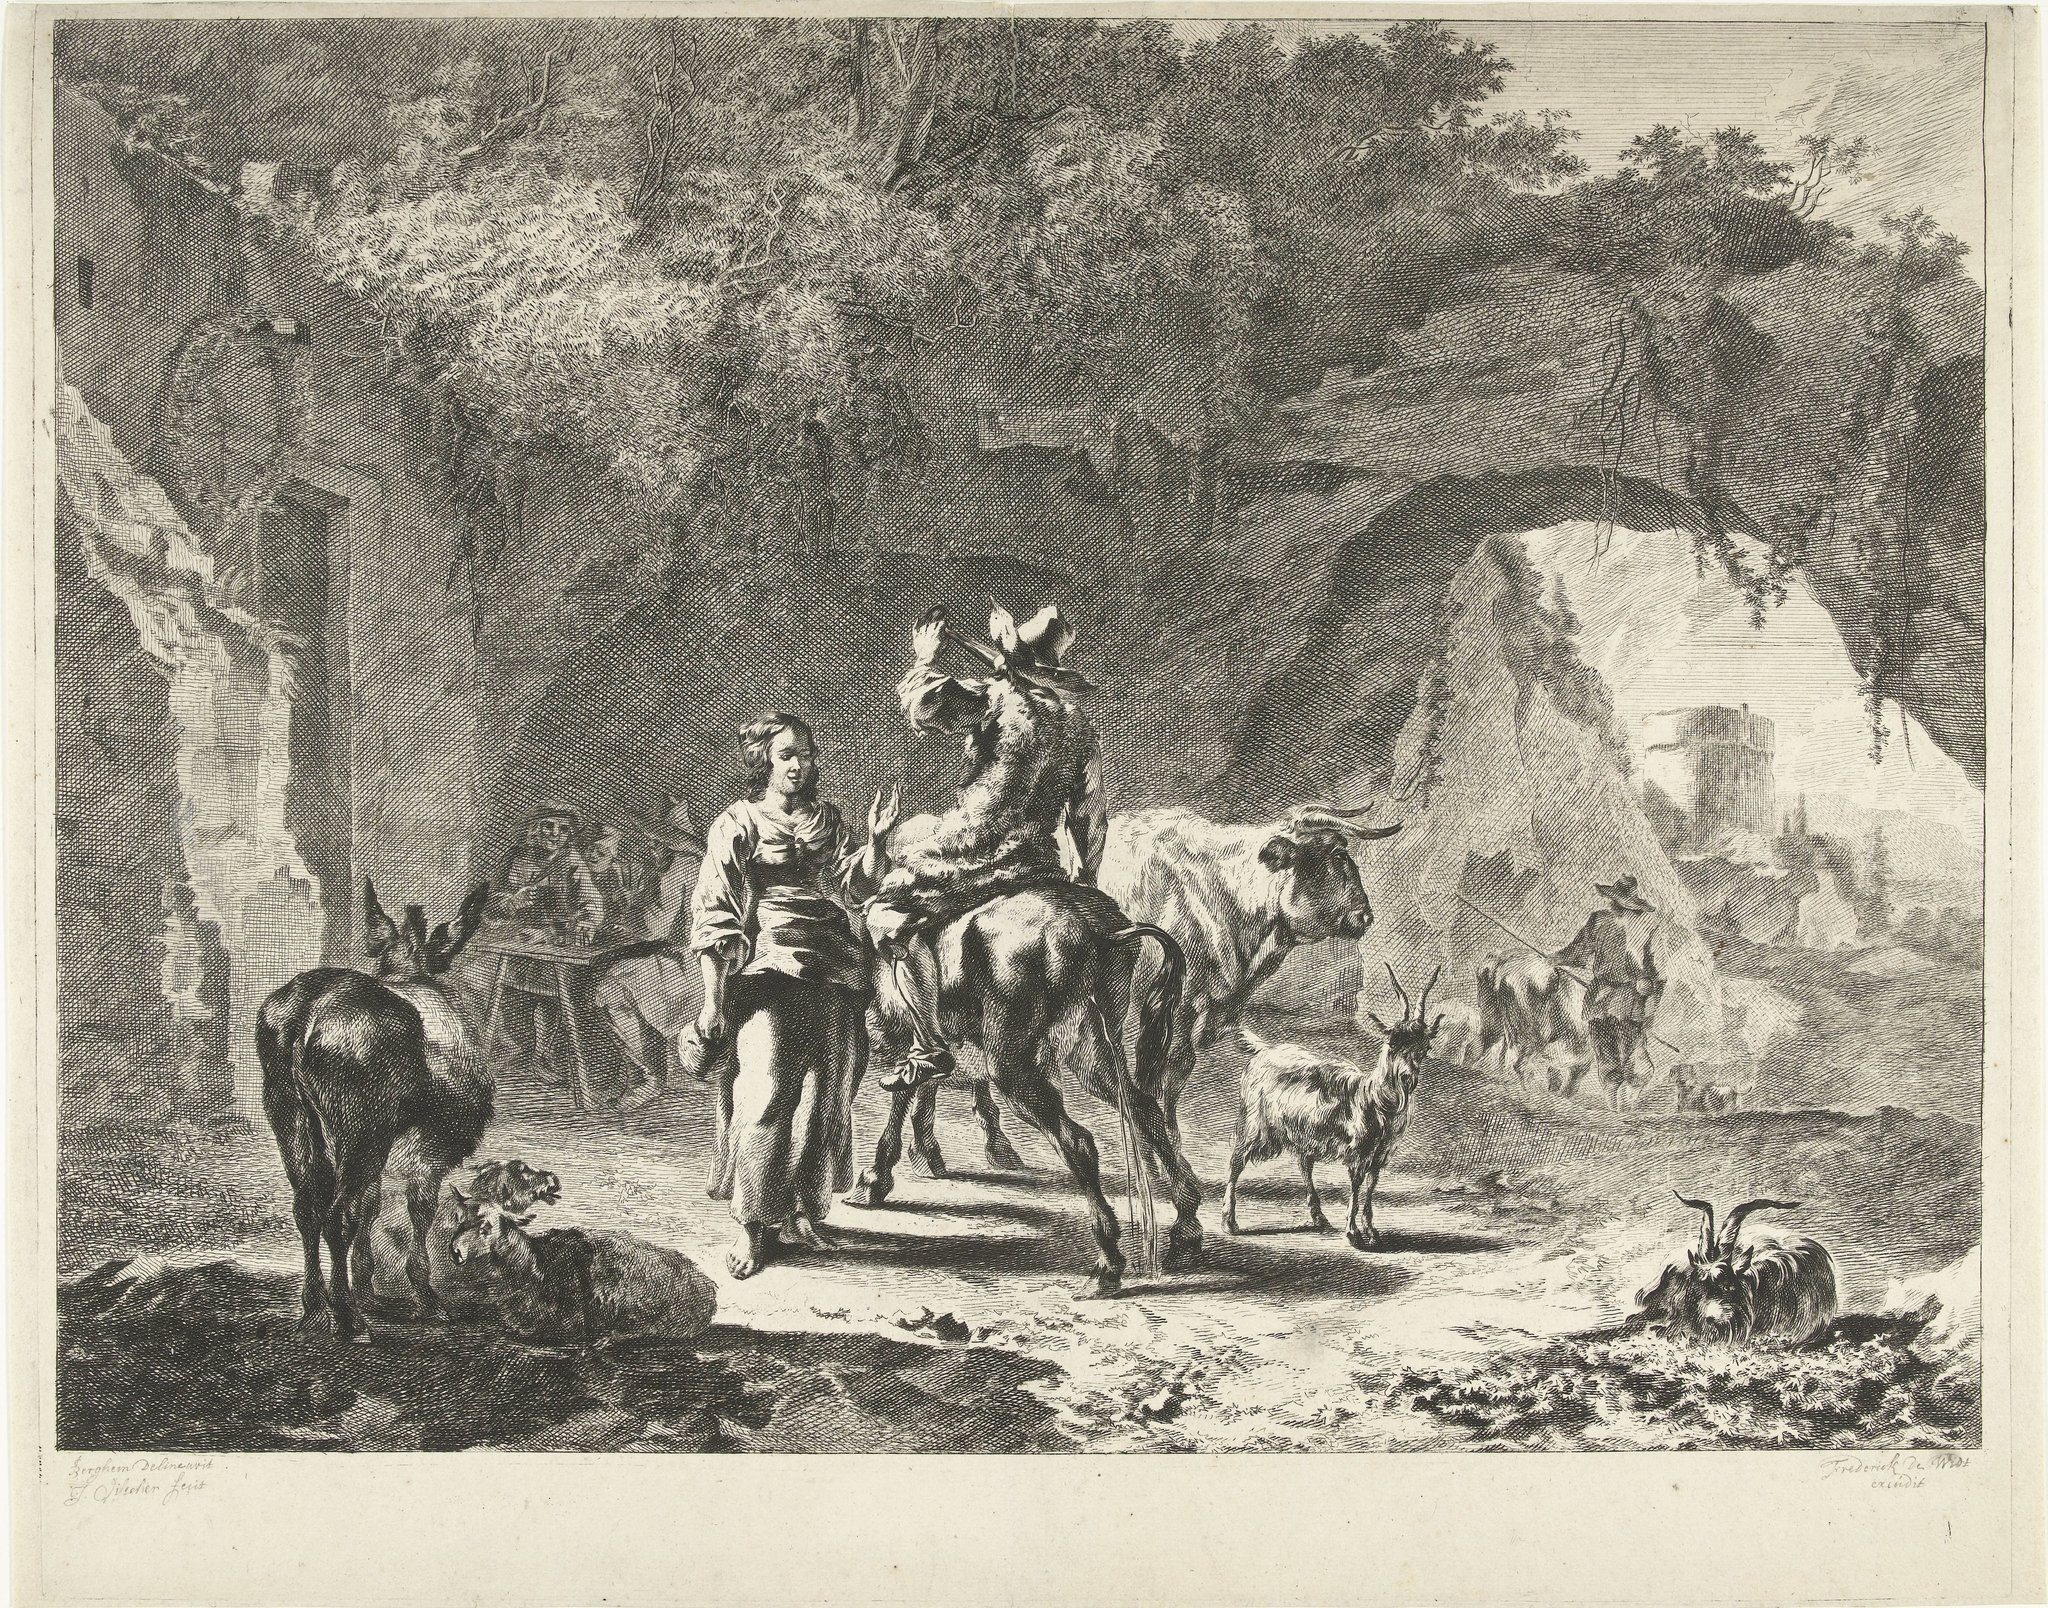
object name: print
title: Tijden van de dag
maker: dancker danckerts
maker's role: print maker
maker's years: 1633-1666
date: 1660-1666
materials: paper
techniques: etching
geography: amsterdam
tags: herding, herdsman, herdswoman, shepherd, shepherdess, cowherd, etc., inn, coffee-house, public house, etc., rocks, evening ~ other concepts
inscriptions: collector's mark: Lugt 240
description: Herder zittend op muilezel drinkt glas leeg terwijl het beest staat te plassen voor een herberg in een rots. Een groepje mannen drinkt en rookt aan een tafeltje voor een rotswand. Prent nummer 3 uit serie van vier prenten met tijden van de dag.